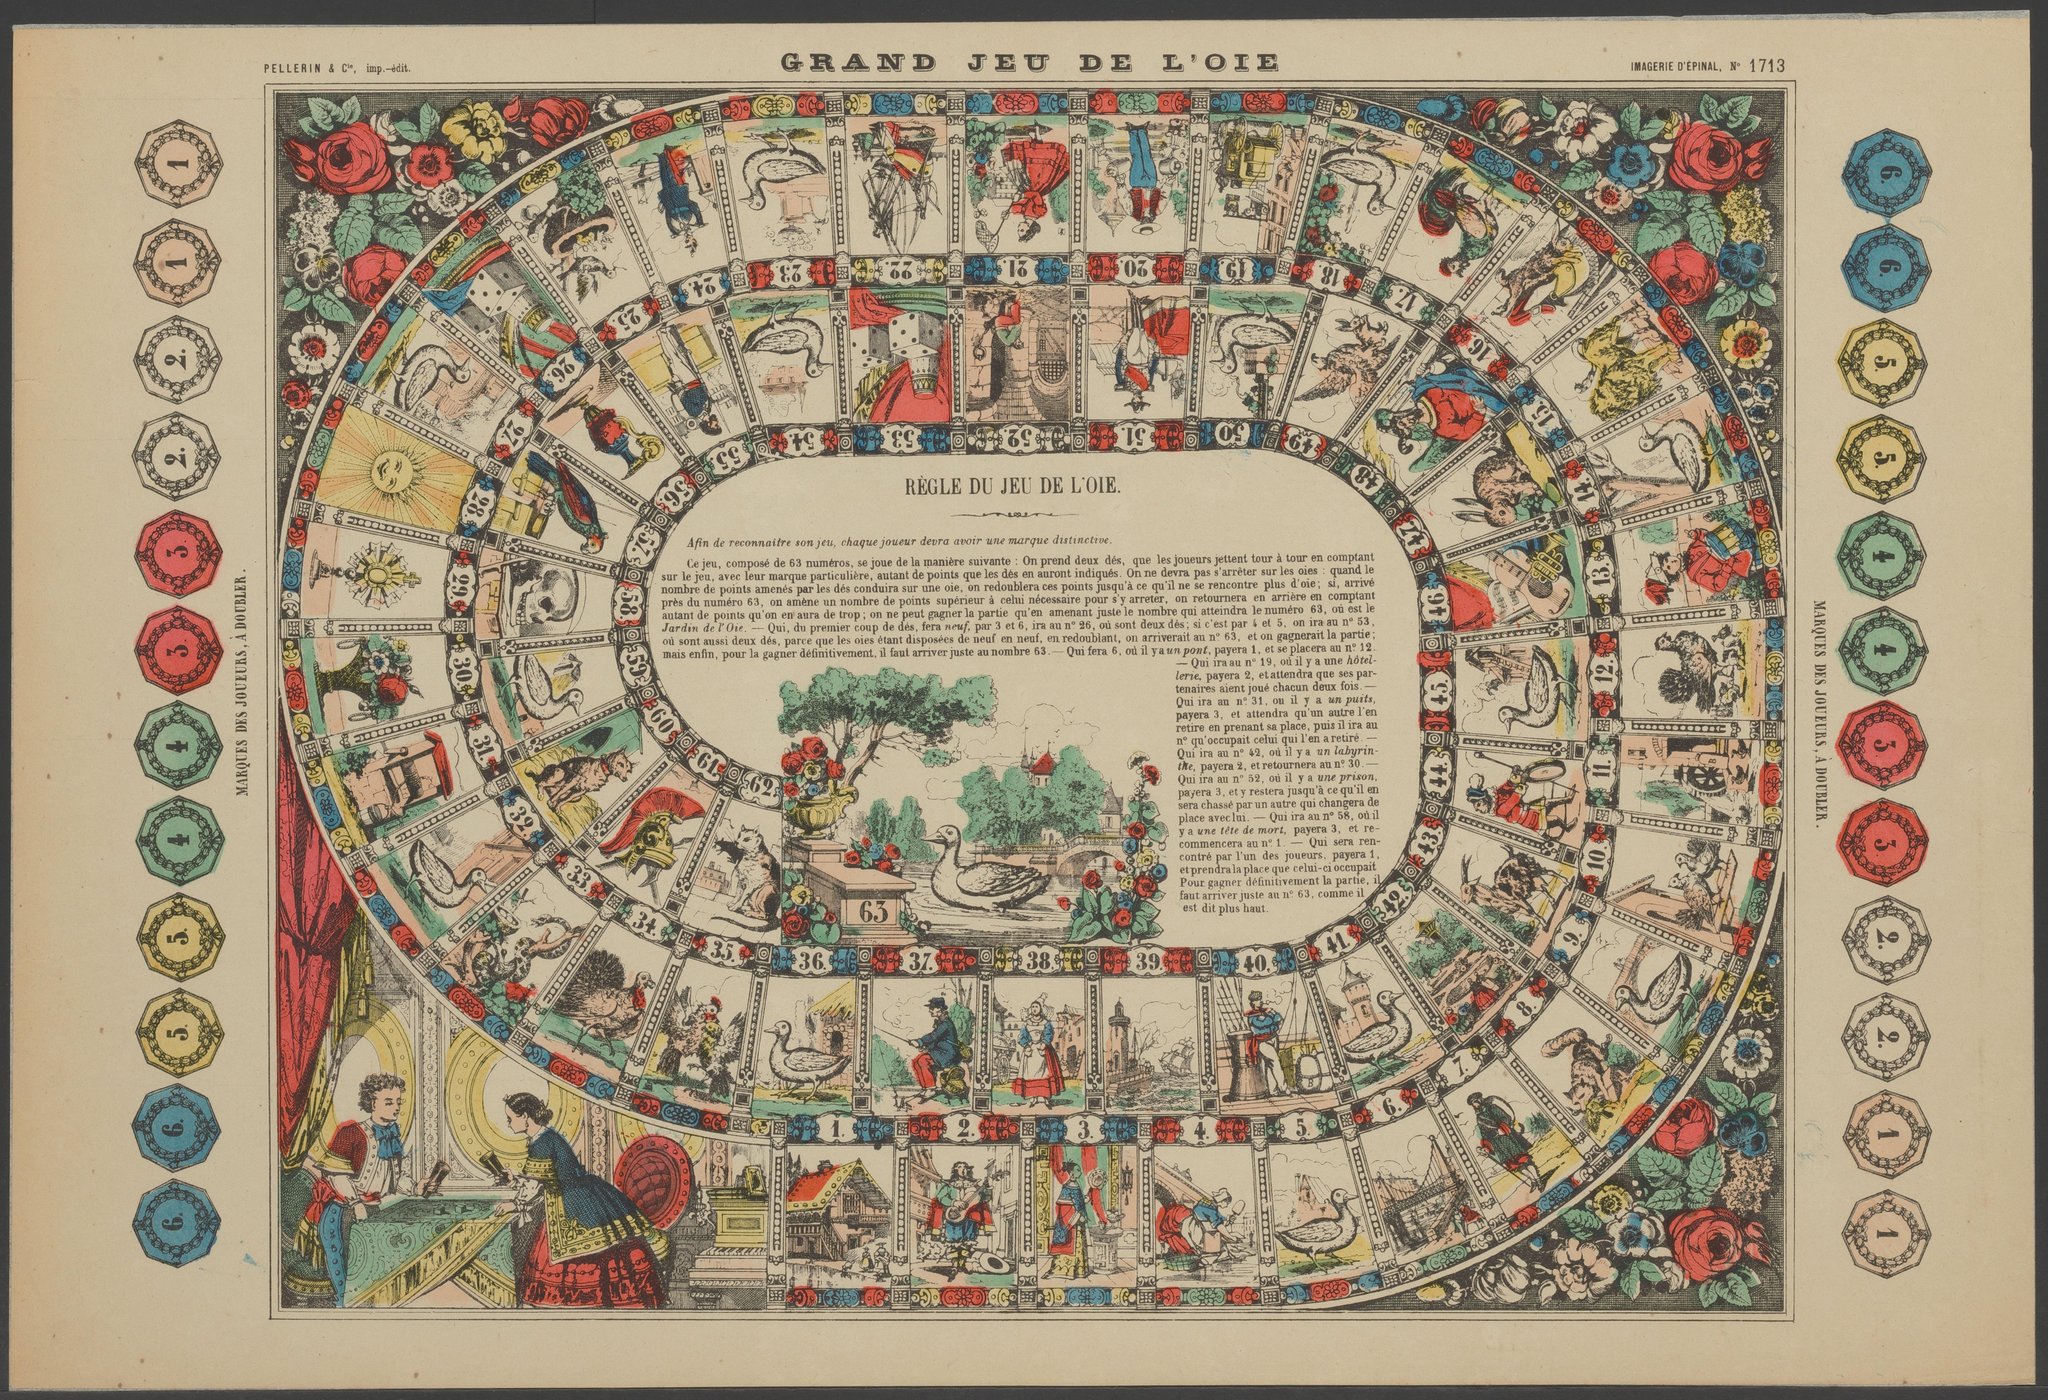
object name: print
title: Speelbord voor ganzenbord met bloemen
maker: Anonymous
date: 1796-1899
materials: paper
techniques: hand coloring, letterpress printing, lithograph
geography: epinal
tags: goose-game, board-games of chance, board-games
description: Ganzenbordspel met een spiraal met vakken genummerd van 1 tot en met 63. In alle vakken voorstellingen, zoals van ganzen, gebouwen, dieren en menselijke figuren. Middenin spelregels in het Frans. Linksonder een jongen en meisje met bekers in hun hand waarmee de dobbelstenen worden geschud. In de overige hoeken bloemenornamenten. Rechtsboven genummerd: No 1713. Onderwerpsrubrieken binnen de Atlas Zeden en Gewoonten: Zeden en gewoonten in engeren zin, Spel en vermaak, Gezelschapsspel II, Ganzenbord en dergelijke.